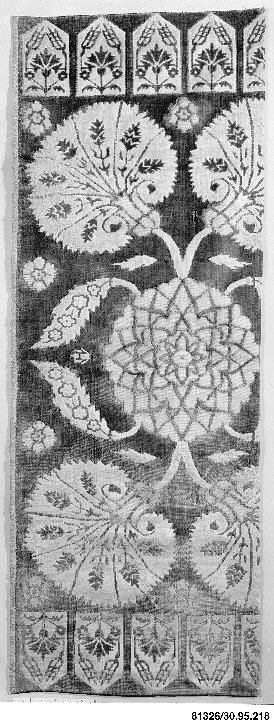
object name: panel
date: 1601-1700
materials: metal thread, silk, velvet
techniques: cutting, voiding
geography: turkey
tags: flowers,leaves